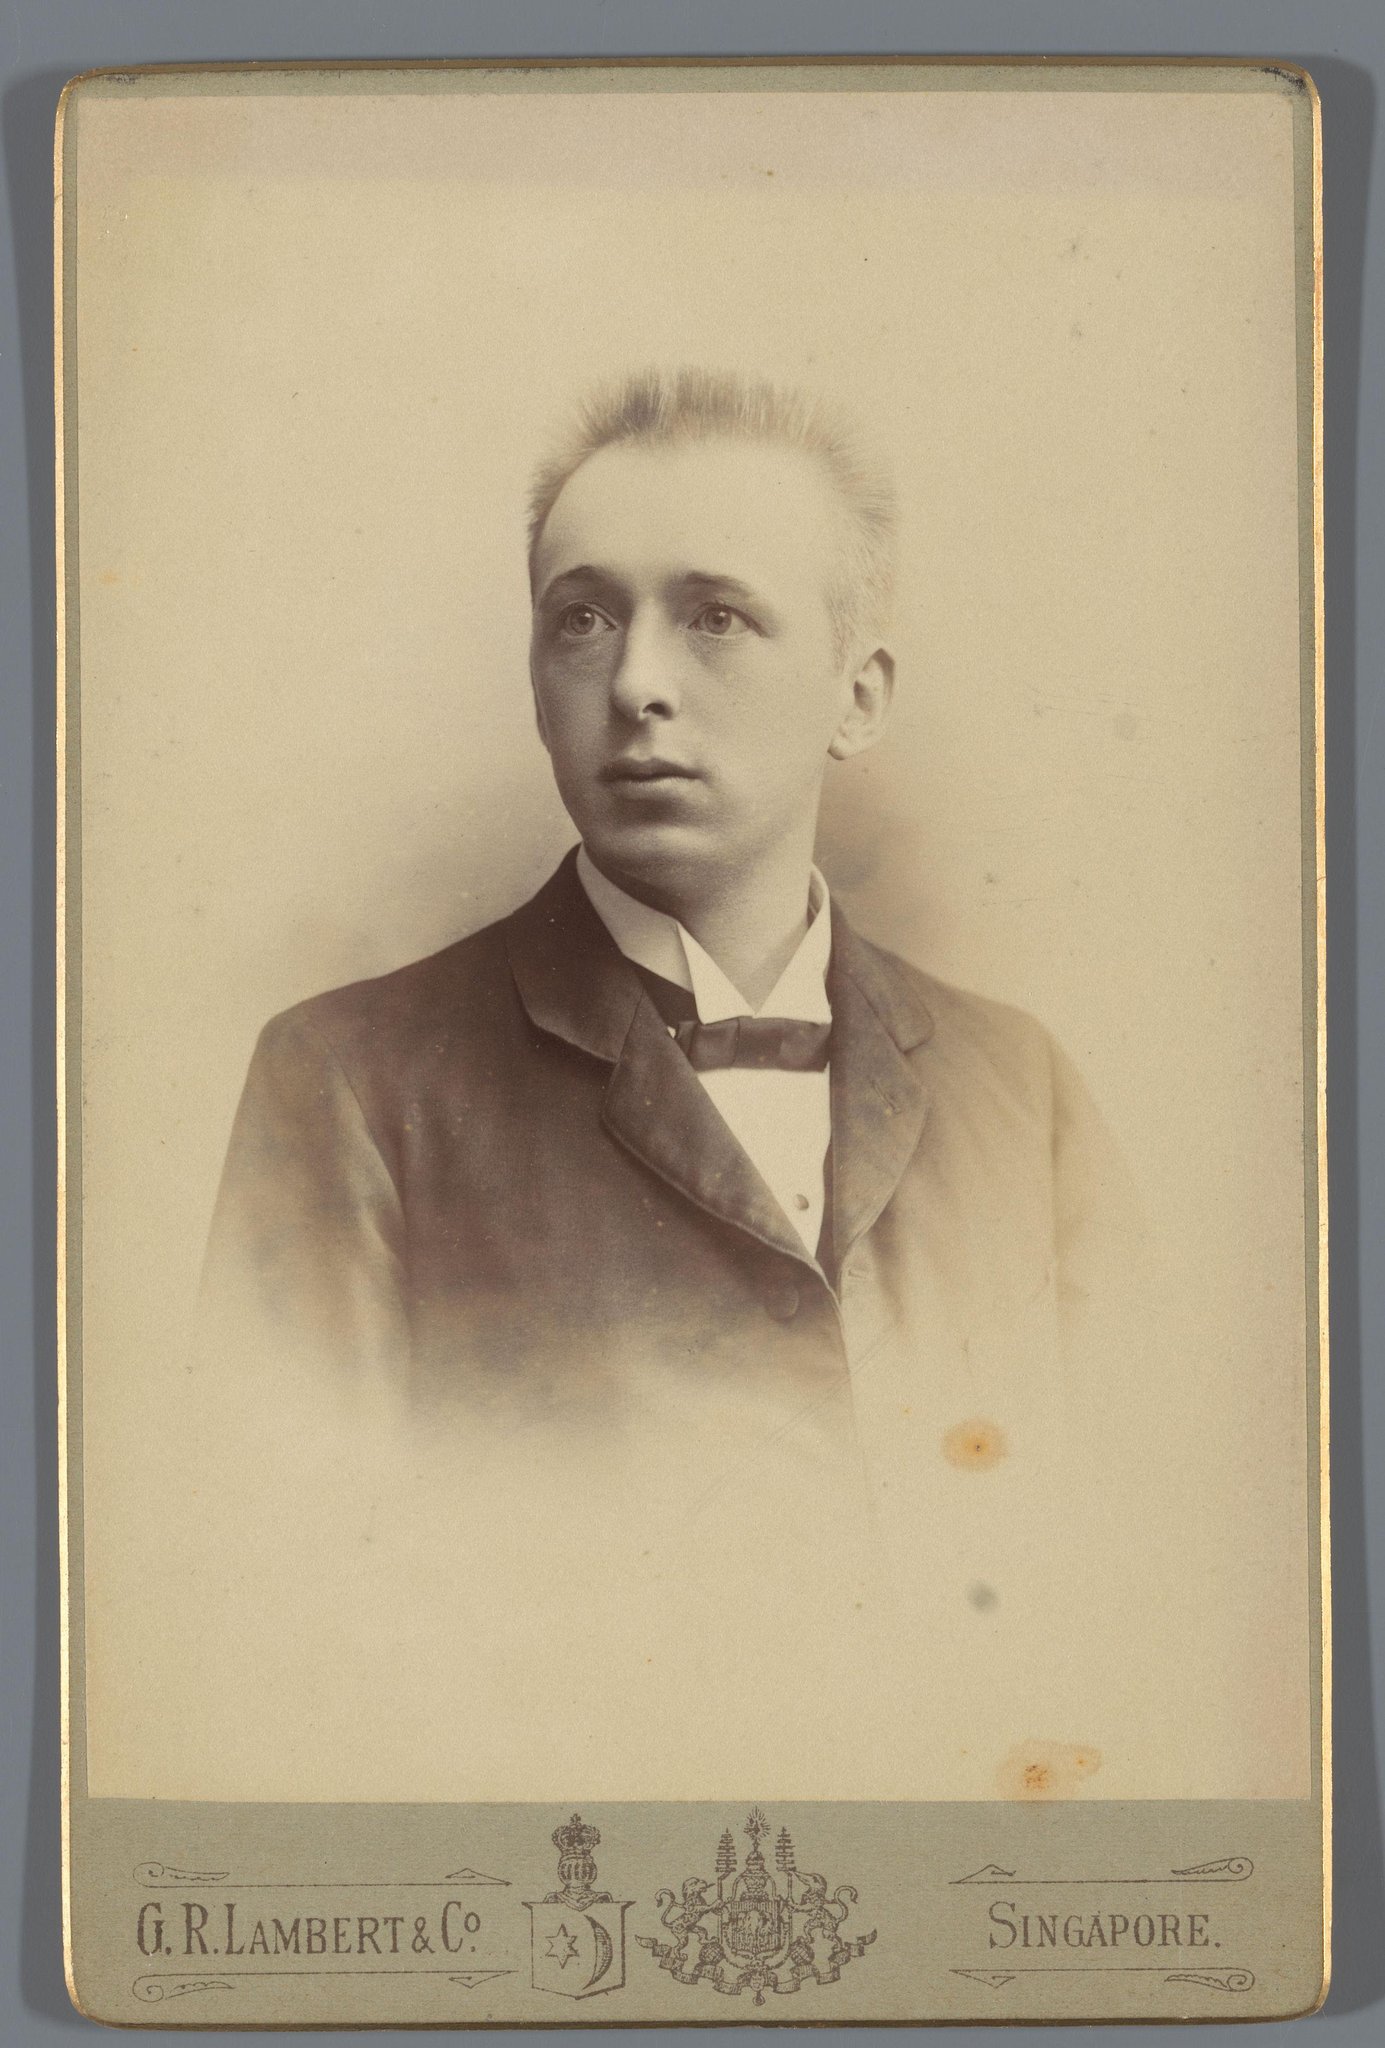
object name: photograph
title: Portret van A.F. Marmelstein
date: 1870-1900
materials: cardboard, photographic support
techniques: albumen print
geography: singapore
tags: adult man, historical persons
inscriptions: retailer's mark: ‘Photographers/ By appointment/ To H.M. the King of Siam/ and/ to H.R.H the Sultan/ of Johroe/ (...)’